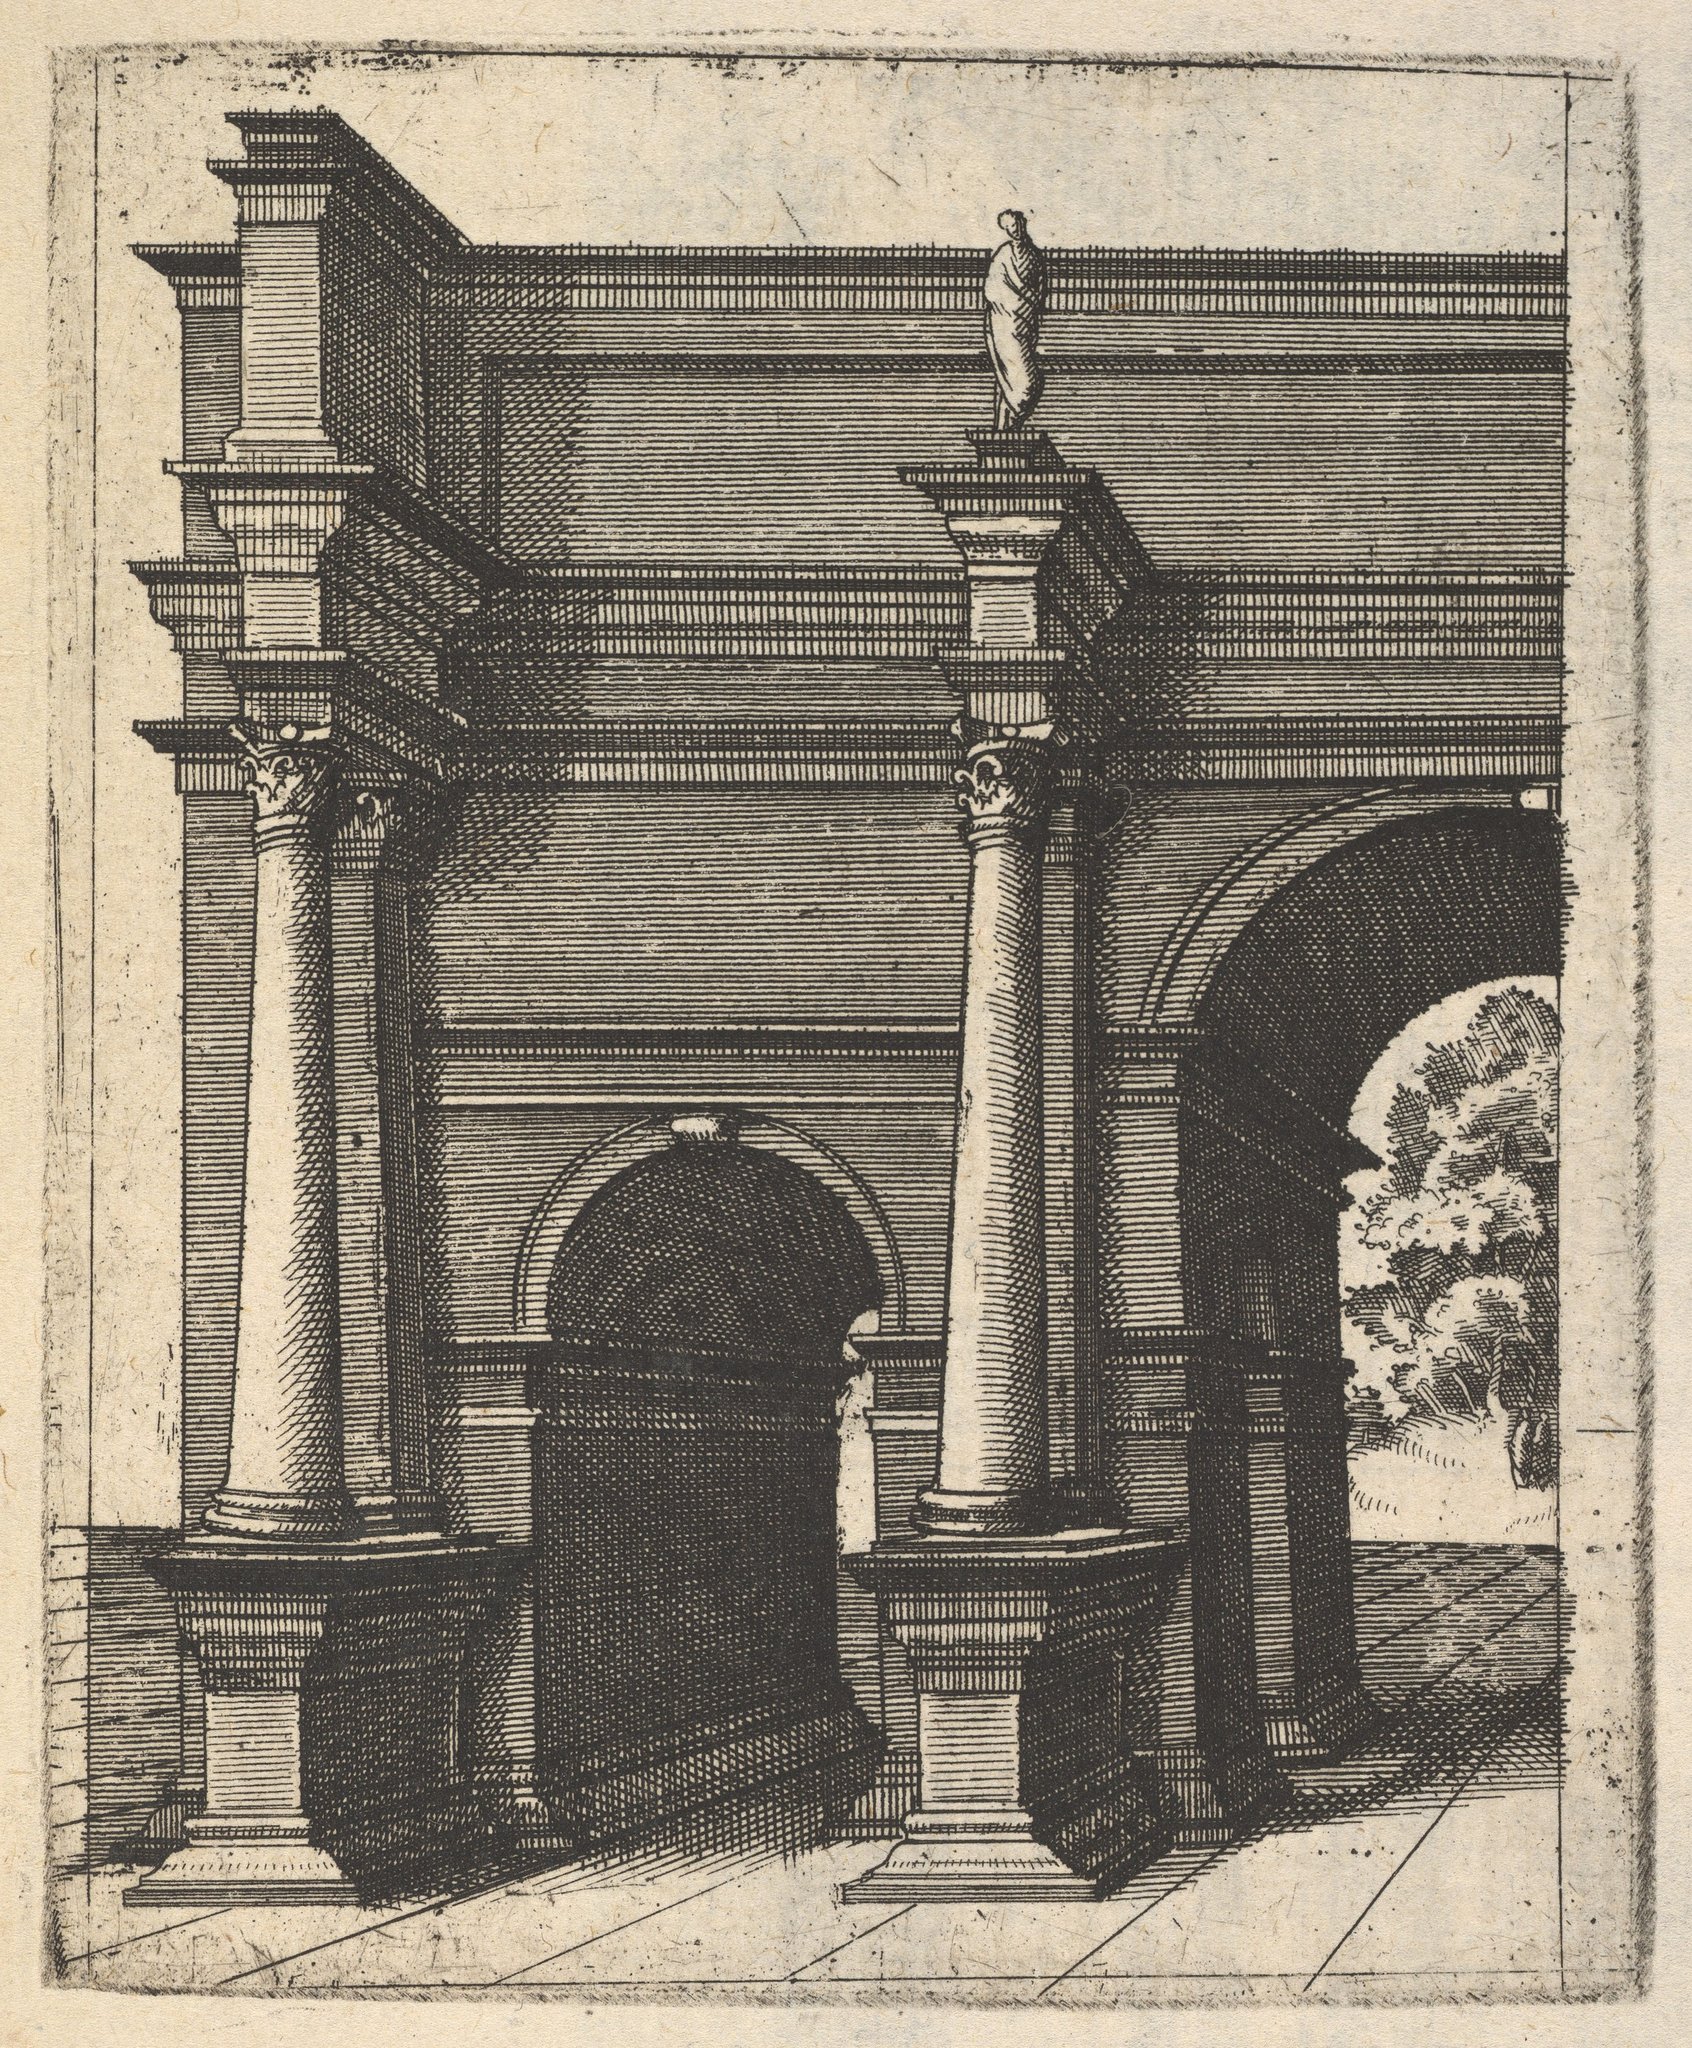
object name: book print ornament architecture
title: Half of an Arch [Arcus Lutii Septimi] from the series 'Ruinarum variarum fabricarum delineationes pictoribus caeterisque id genus artificibus multum utiles'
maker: lambert suavius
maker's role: artist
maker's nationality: netherlandish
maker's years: 1510-1576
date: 1554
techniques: etching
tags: architecture,arches